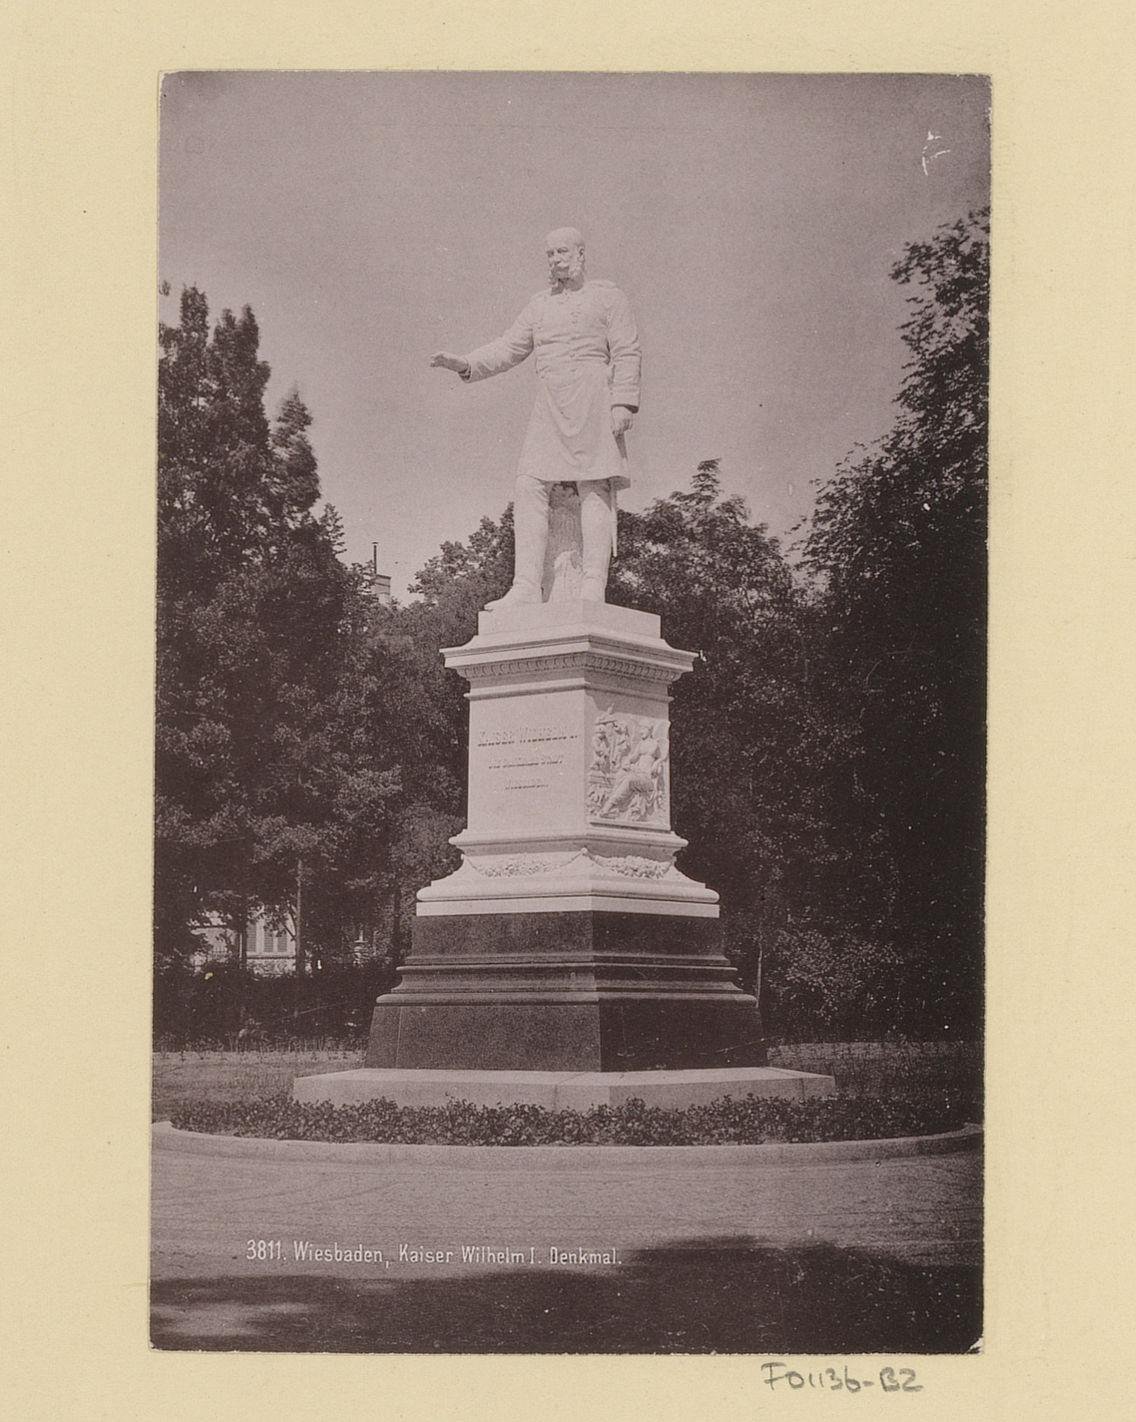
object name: photomechanical print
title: Monument voor keizer Wilhelm I in Wiesbaden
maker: Anonymous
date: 1894-1895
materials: paper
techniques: photograph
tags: berlin, wilhelm i (keizer van duitsland), monument, statue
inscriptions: number: ‘3811’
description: Onderdeel van Fotoalbum met opnames van bezienswaardigheden in België, Duitsland en Noorwegen.